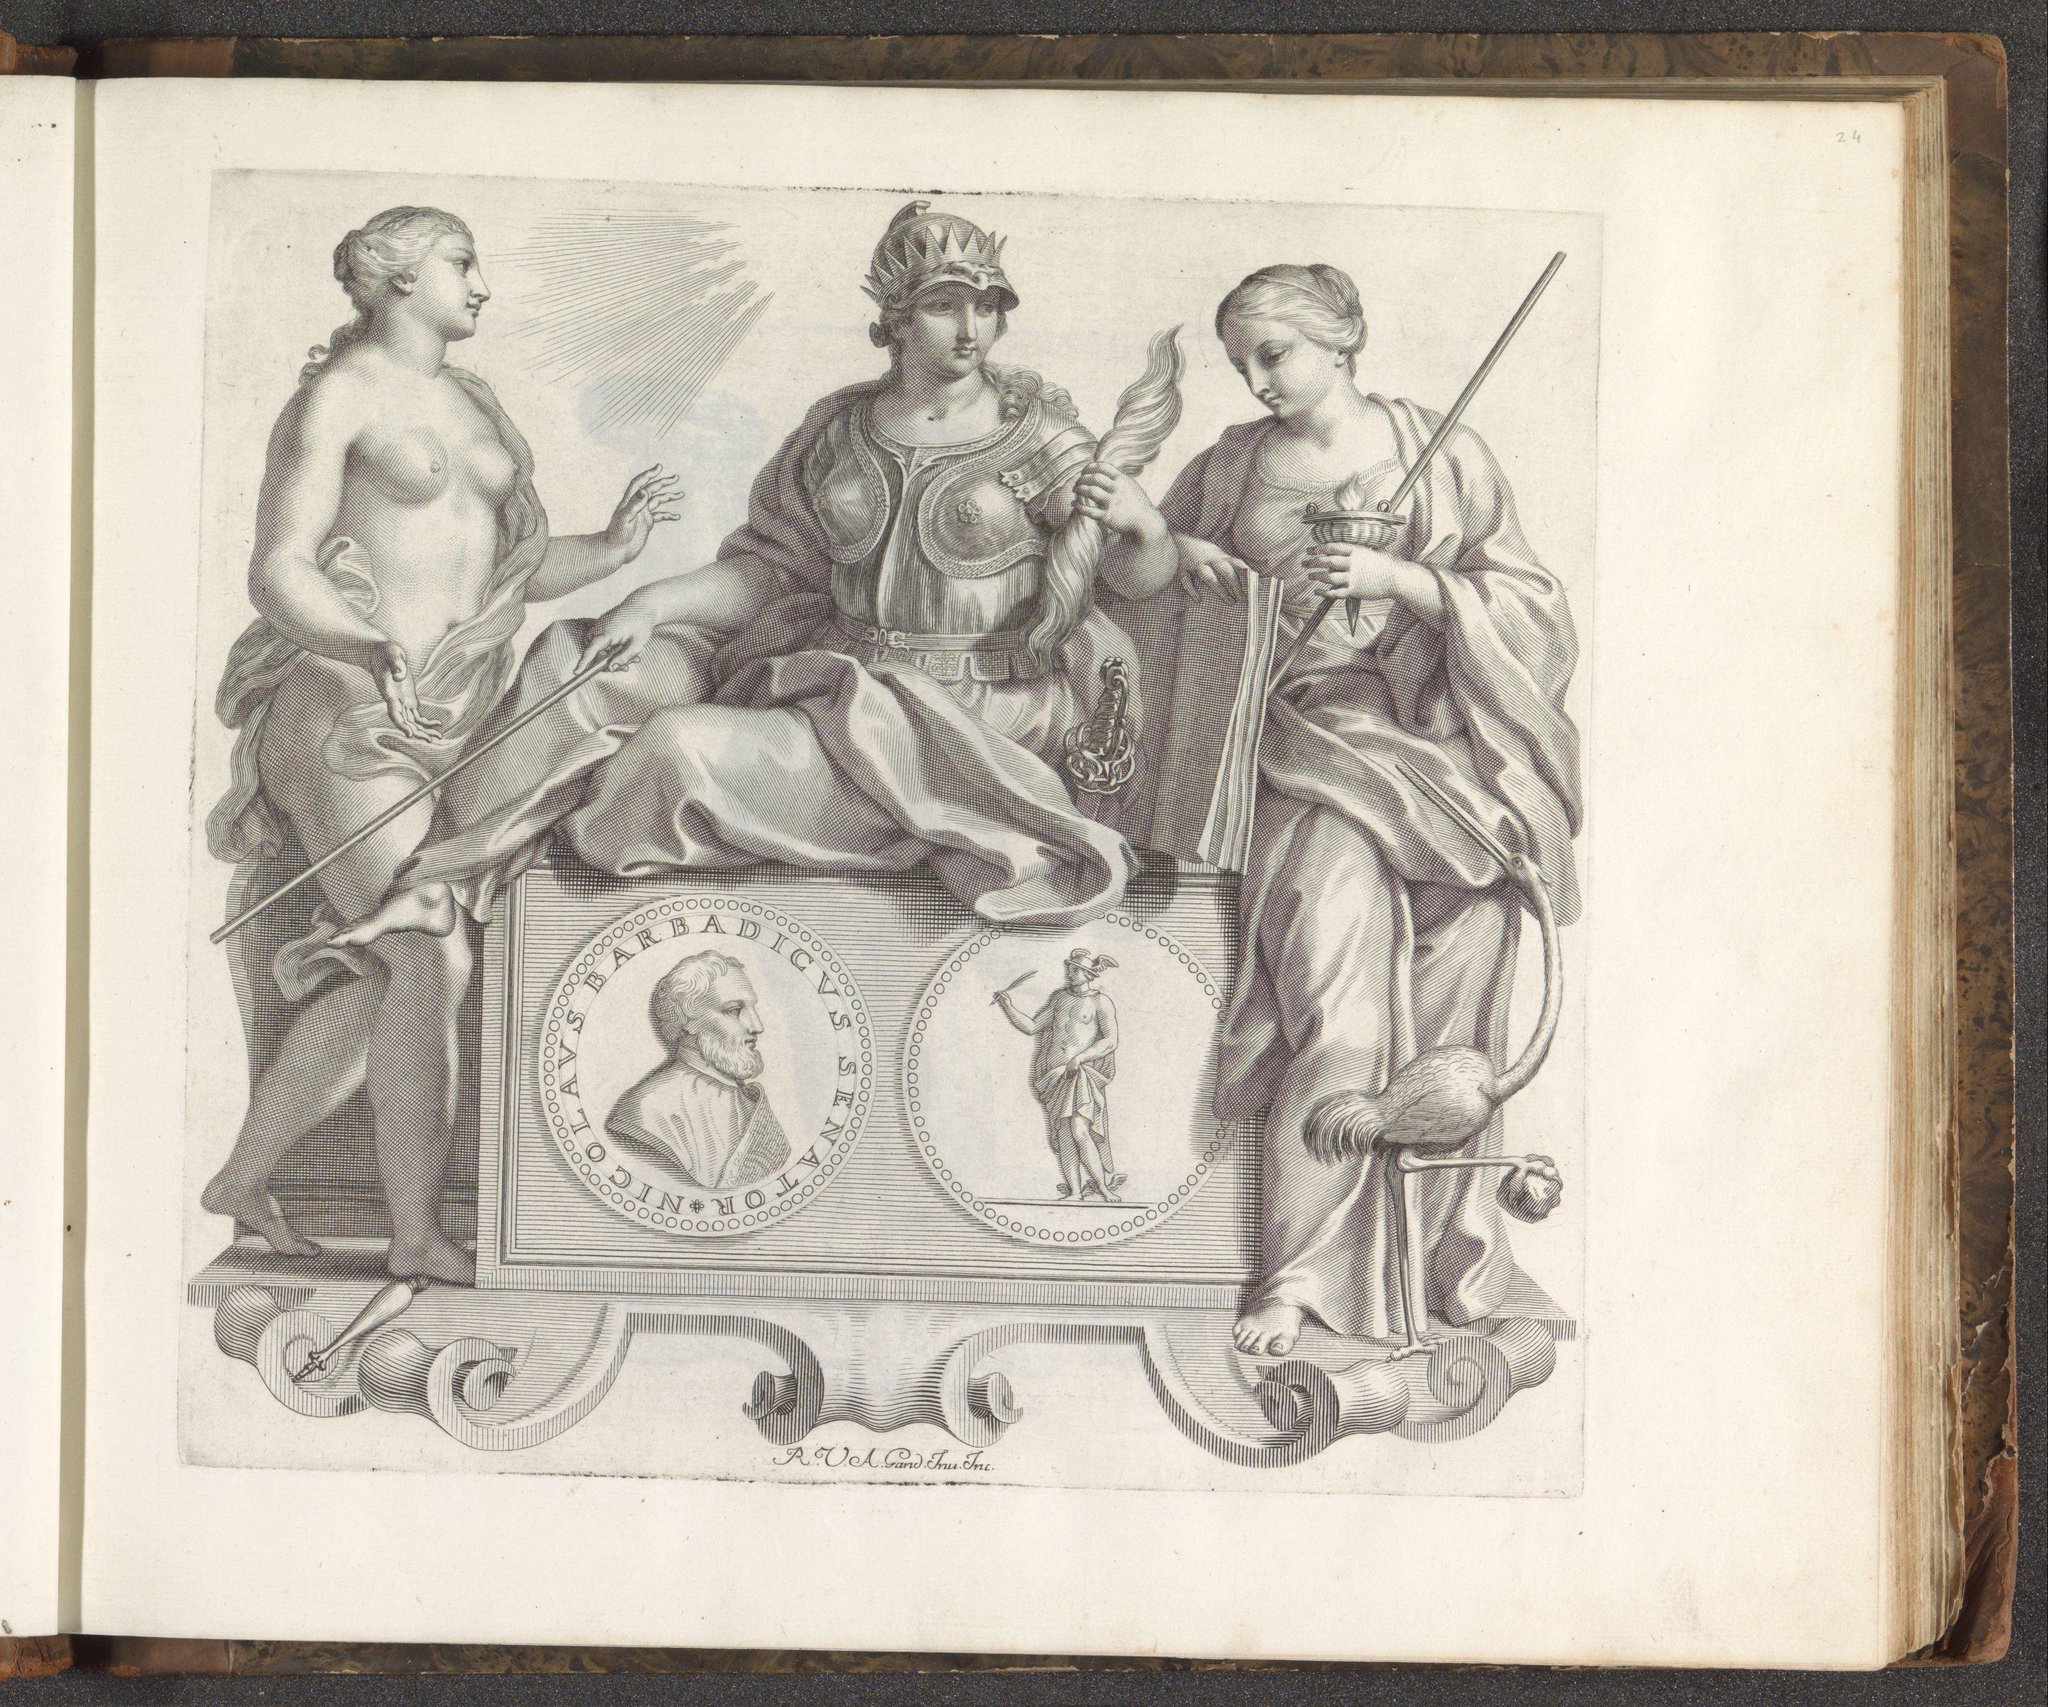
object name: album leaf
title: Numismata virorum illustrium ex Barbadica gente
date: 1673-1743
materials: paper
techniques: engraving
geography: rome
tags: (story of) minerva (pallas, athena), (story of) mercury (hermes), wisdom; 'sapienza', 'sapienza humana', 'sapienza vera' (ripa), medal (considered as a piece of sculpture, regardless of its specific function), eloquence; 'eloquenza', 'fermezza & gravità dell'oratione' (ripa), alertness, vigilance; 'guardia', 'vigilanza', 'vigilanza per difendersi & oppugnare altri' (ripa)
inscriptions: collector's mark: Lugt 2228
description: Voetstuk in de vorm van een cartouche. Daarop een medaillon met op de voorzijde het portret van senator Nicolo Barbarigo. Op de achterzijde Mercurius met een schrijfveer in de hand. Op het voetstuk zit de personificatie van Welsprekendheid: een vrouw met een helm op het hoofd en een kroon. Ze heeft een roede en bliksemschicht in haar handen en een rapier naast zich. Welsprekendheid wordt bijgestaan door Waarheid en door Waakzaamheid. Waarheid is naakte vrouw, haar gezicht gekeerd naar de hemelstralen en staande op een scepter. Ze heeft haar handen vrij. Waakzaamheid betreft een vrouw met boek, roede en toorts. Bij haar voeten een kraanvogel met één poot opgetrokken en een steen in zijn klauw. De prent maakt deel uit van een album.